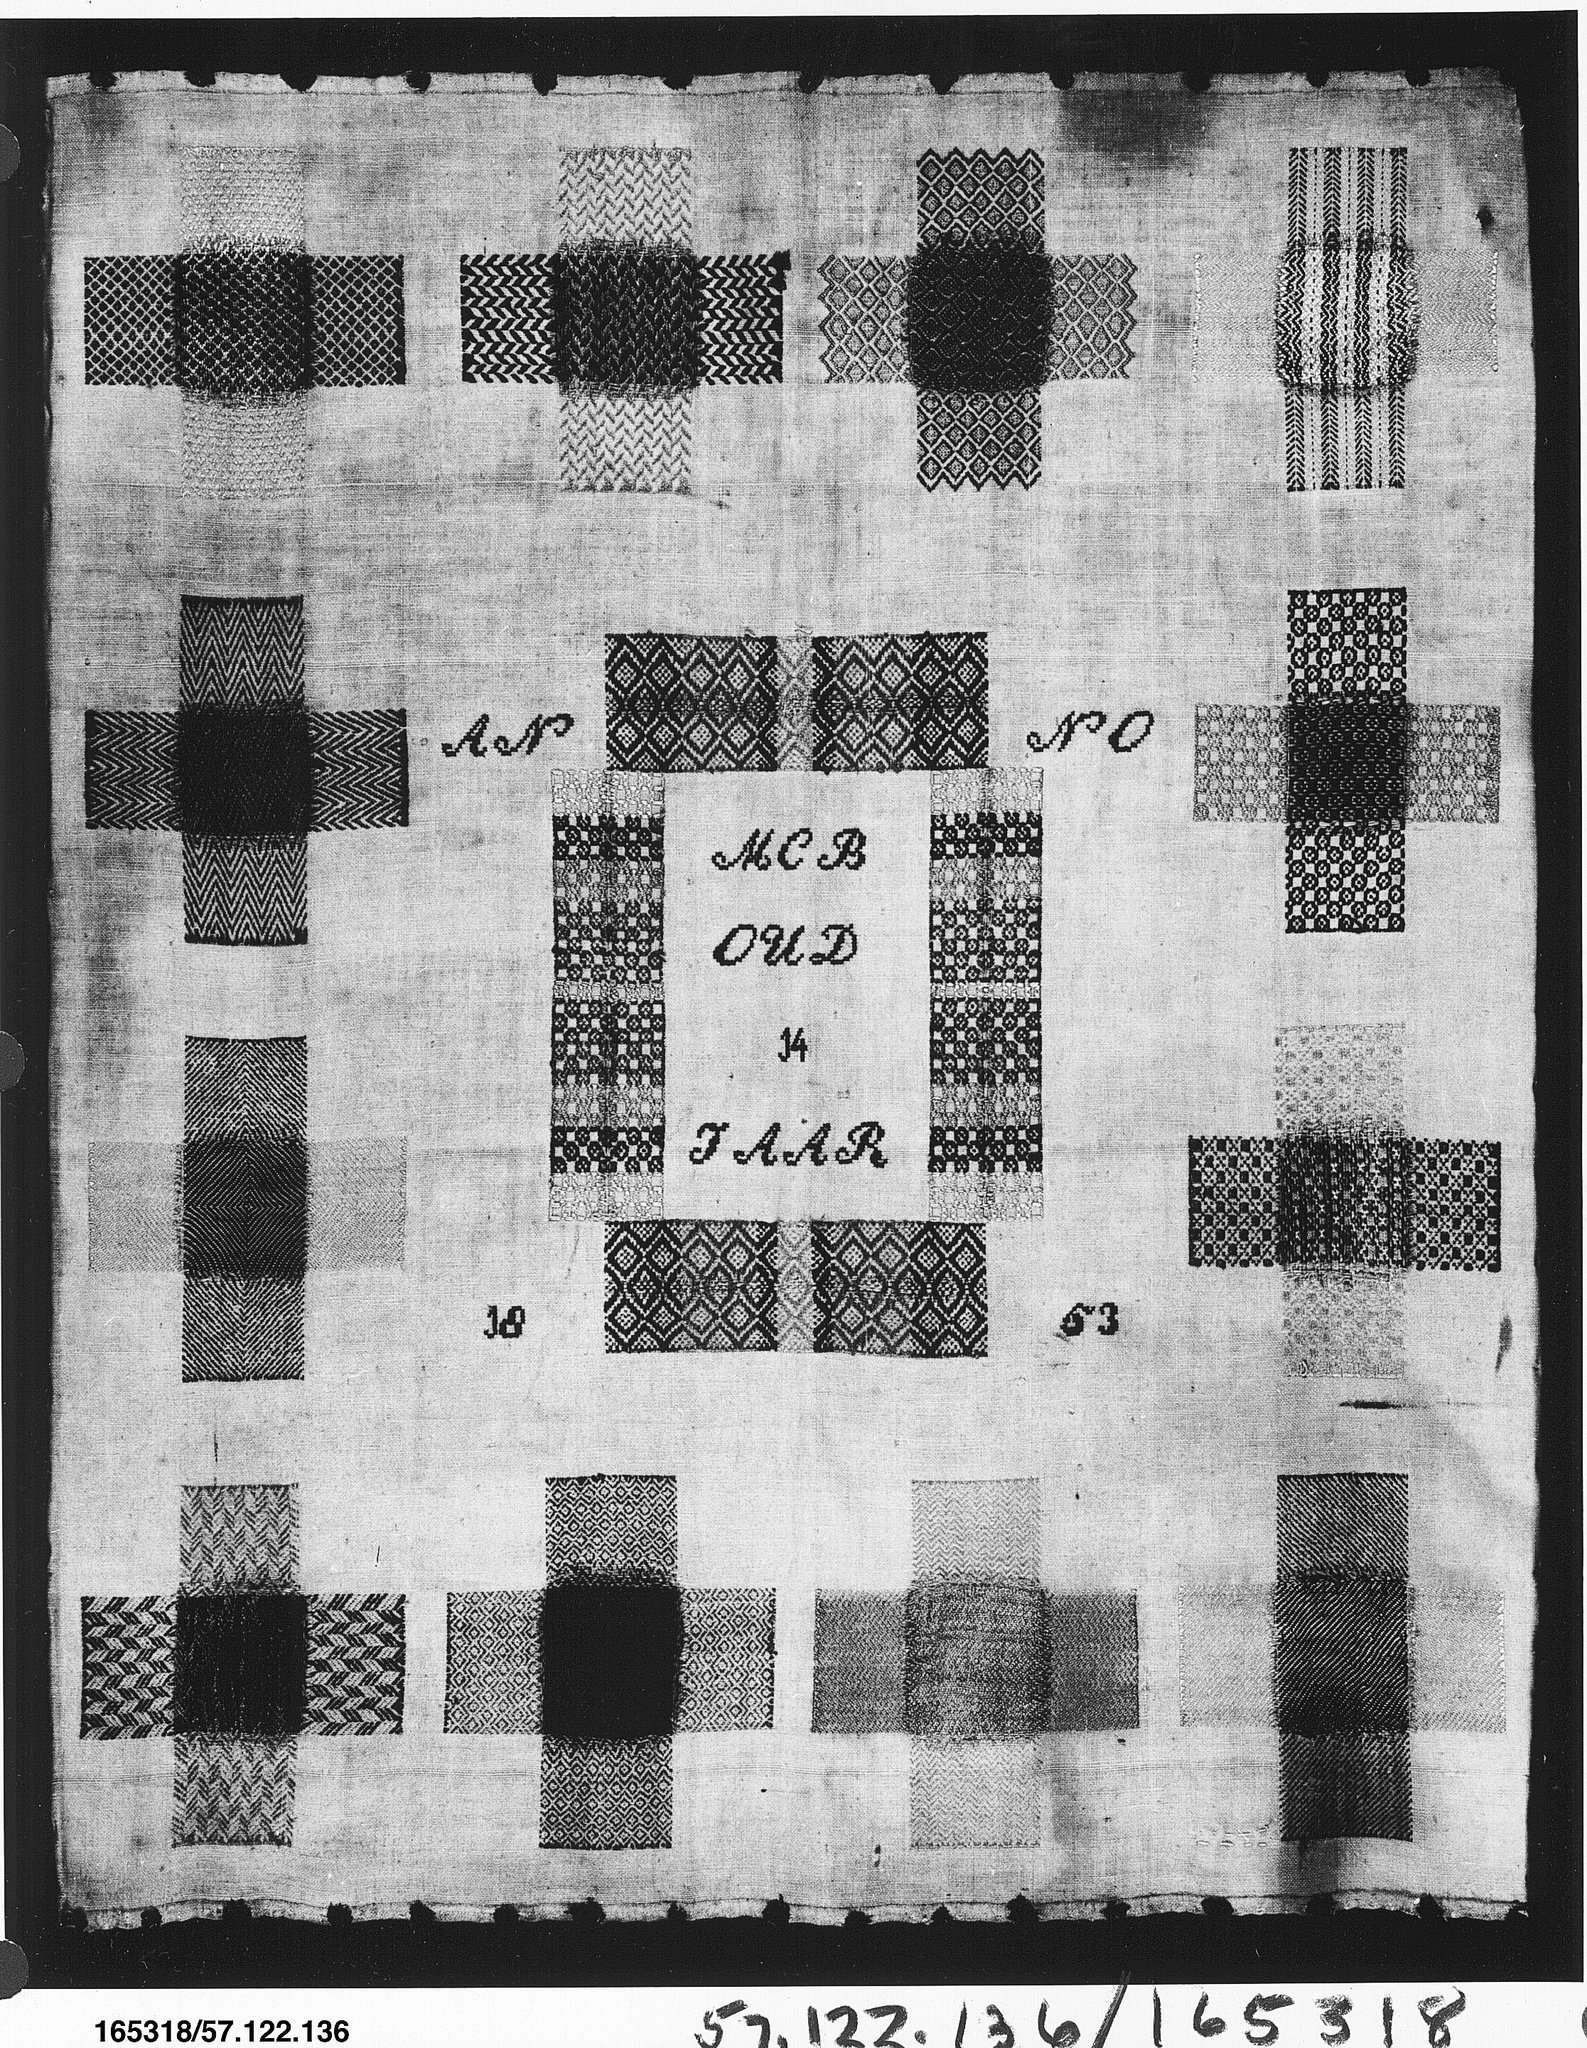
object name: sampler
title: Embroidered darning sampler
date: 1853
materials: cotton, silk